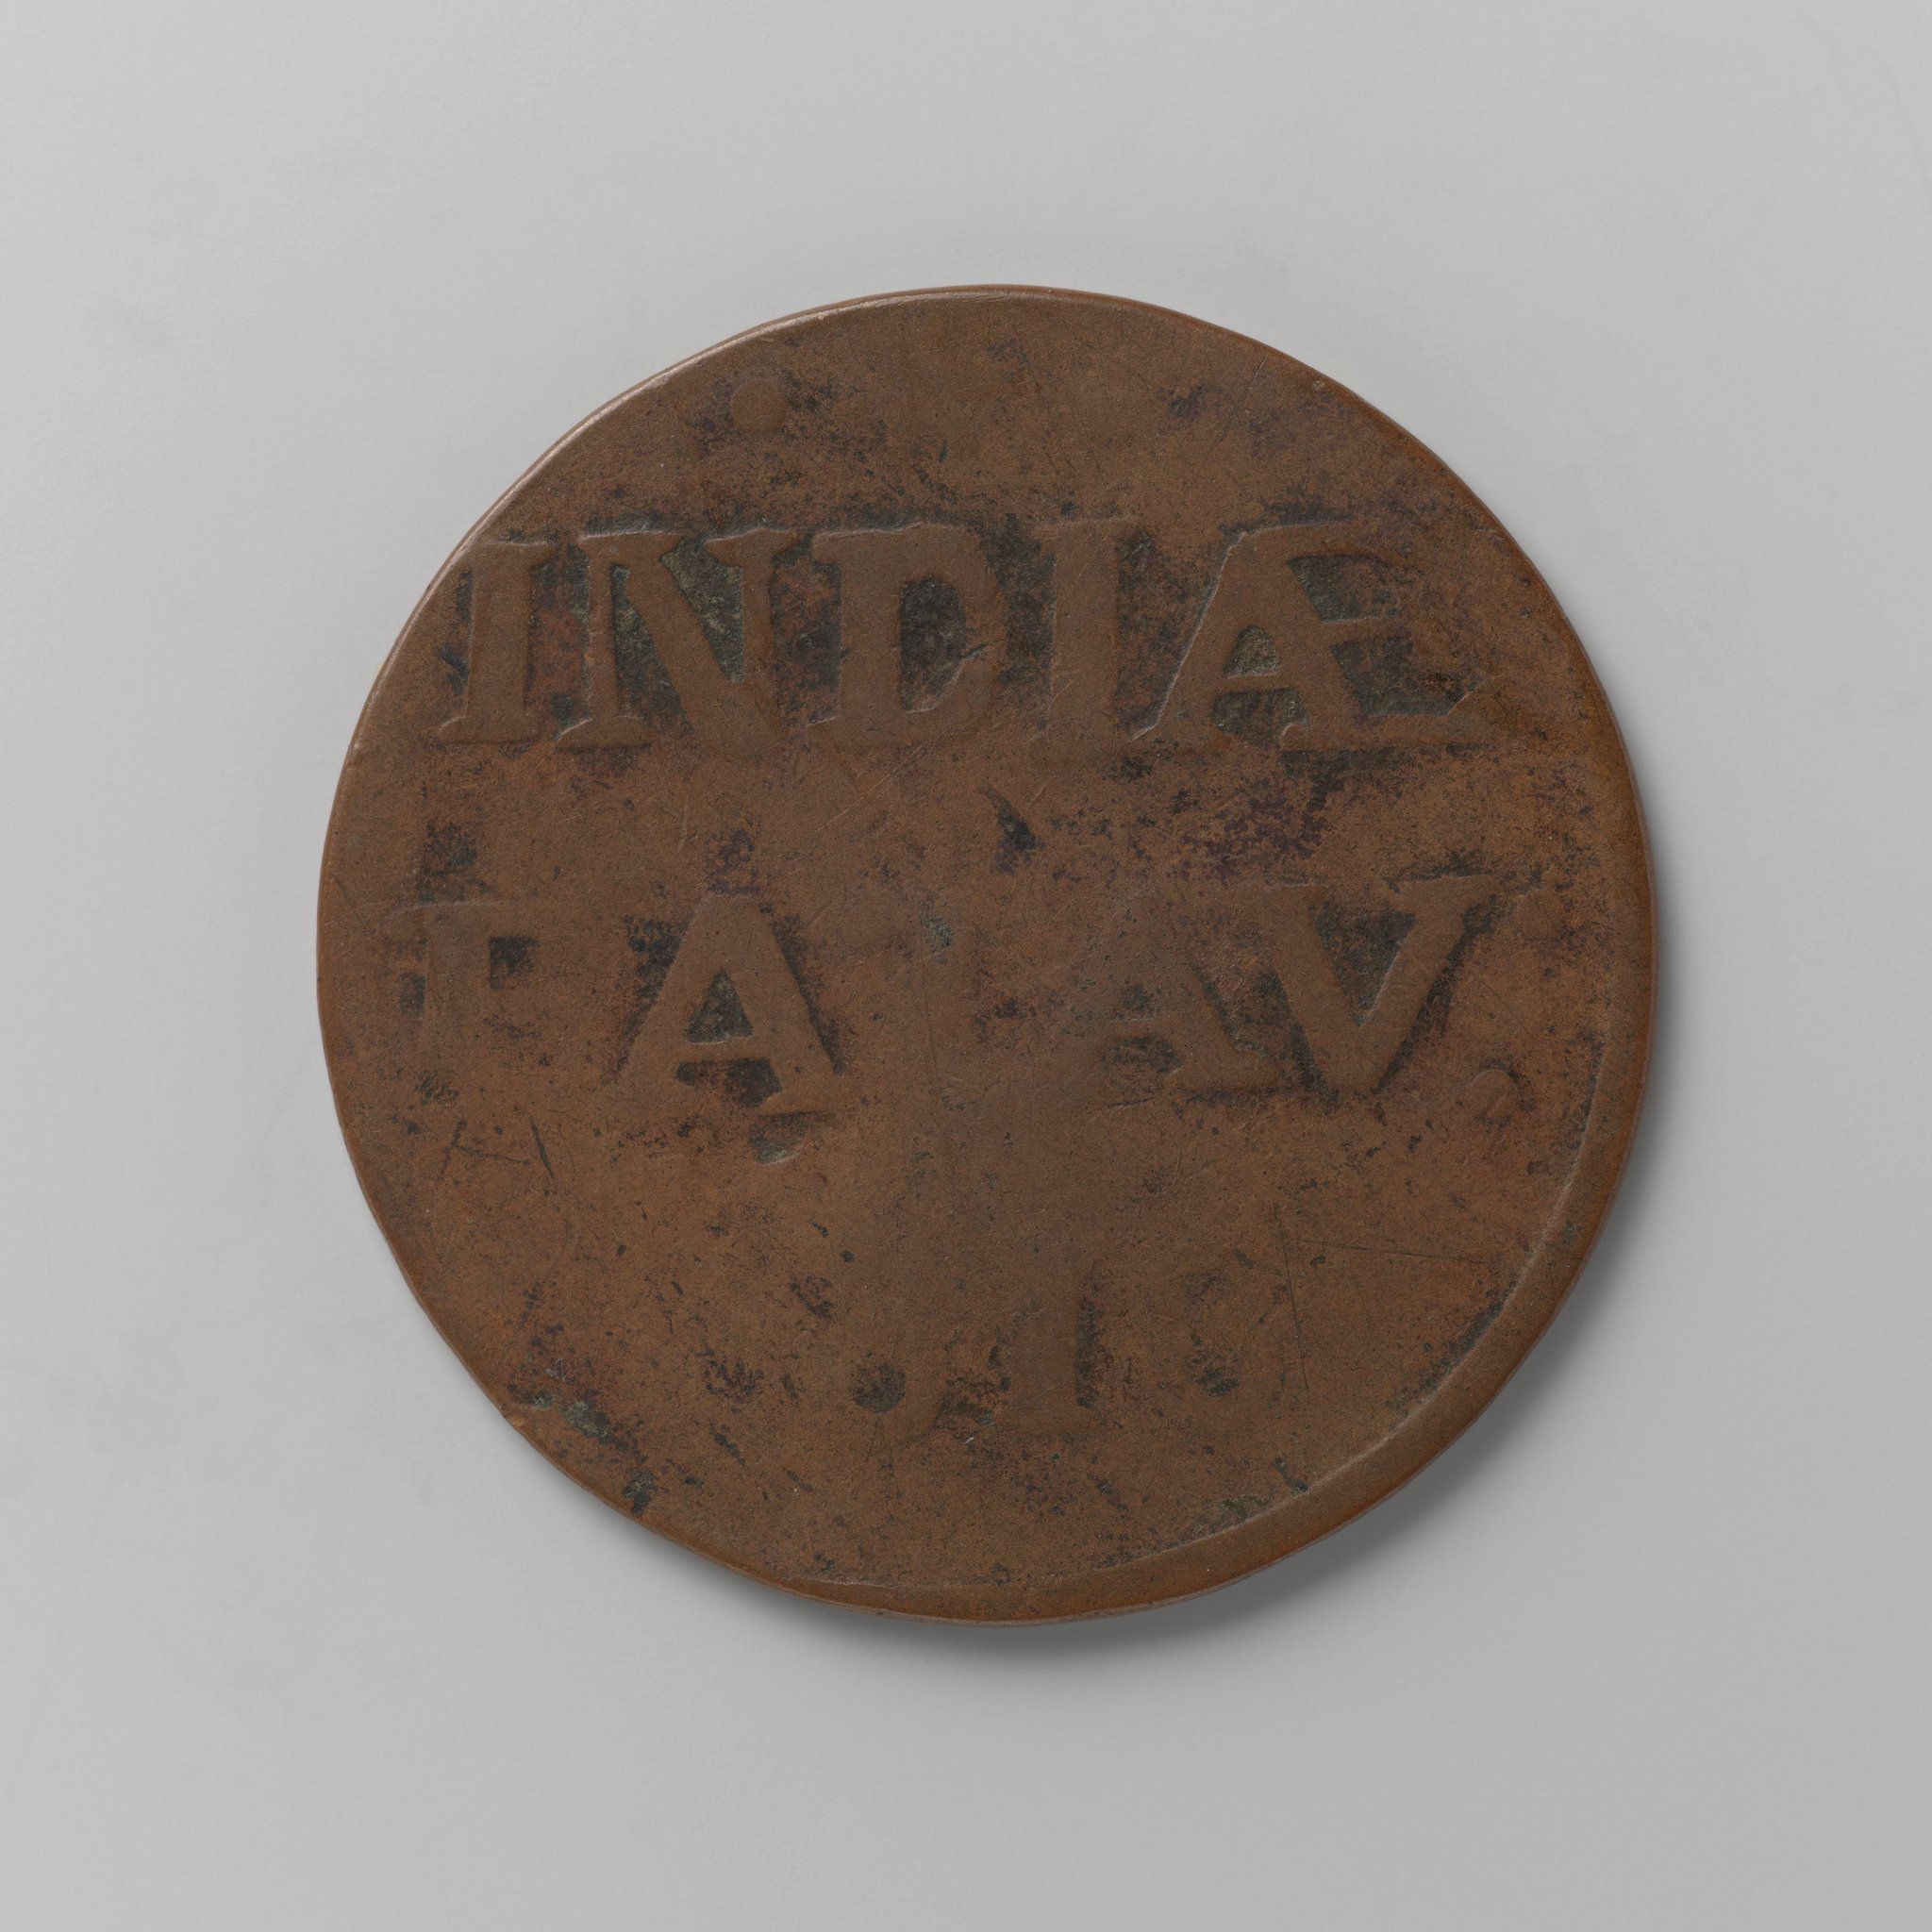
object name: coin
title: ½ stuiver van Nederlands Indië, 1818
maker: william i of the netherlands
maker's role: koning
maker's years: 1772-1843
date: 1818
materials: copper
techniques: striking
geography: surabaya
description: Koperen munt. Voorzijde: tussen waarde-aanduiding ½ St. gekroond generaliteitswapenschild. Daaronder letter G [=gulden!]. Keerzijde: tweeregelig opschrift, waarboven muntteken en waaronder jaartal. Gladde rand.